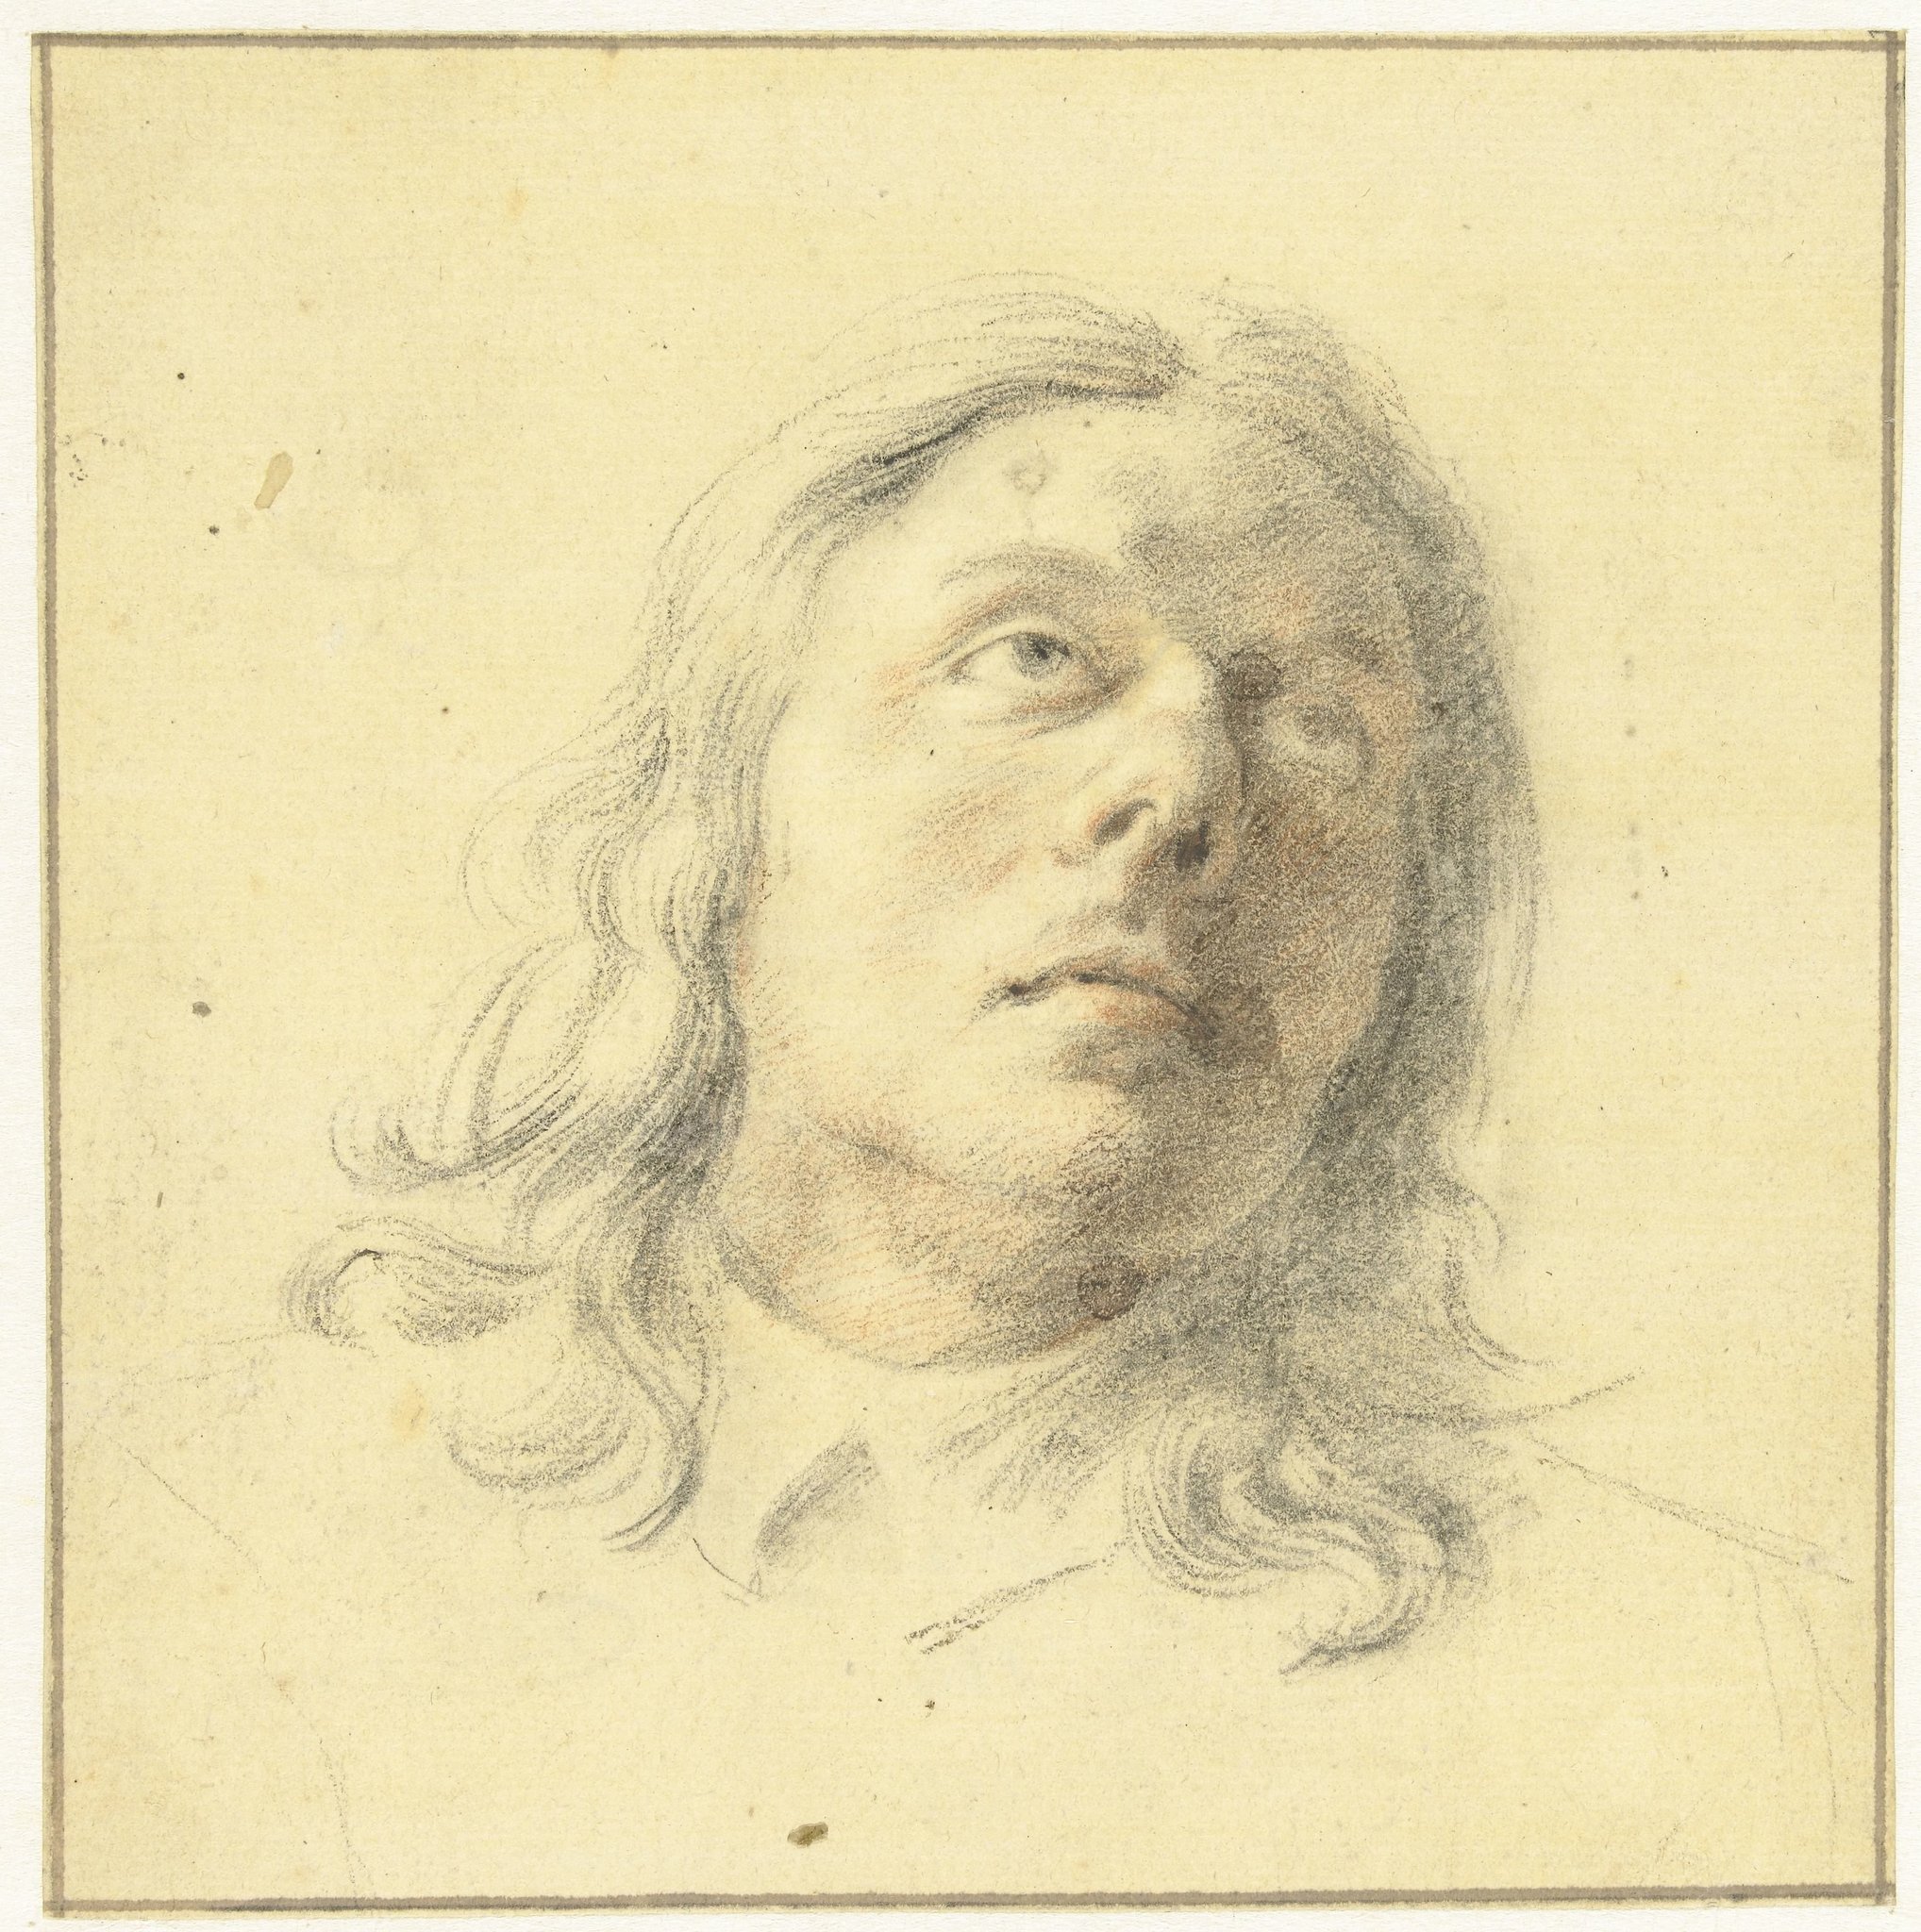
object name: drawing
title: Hoofd van man, opziend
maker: leendert van der cooghen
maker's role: draughtsman, print maker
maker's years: 1632-1681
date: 1642-1681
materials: chalk, paper